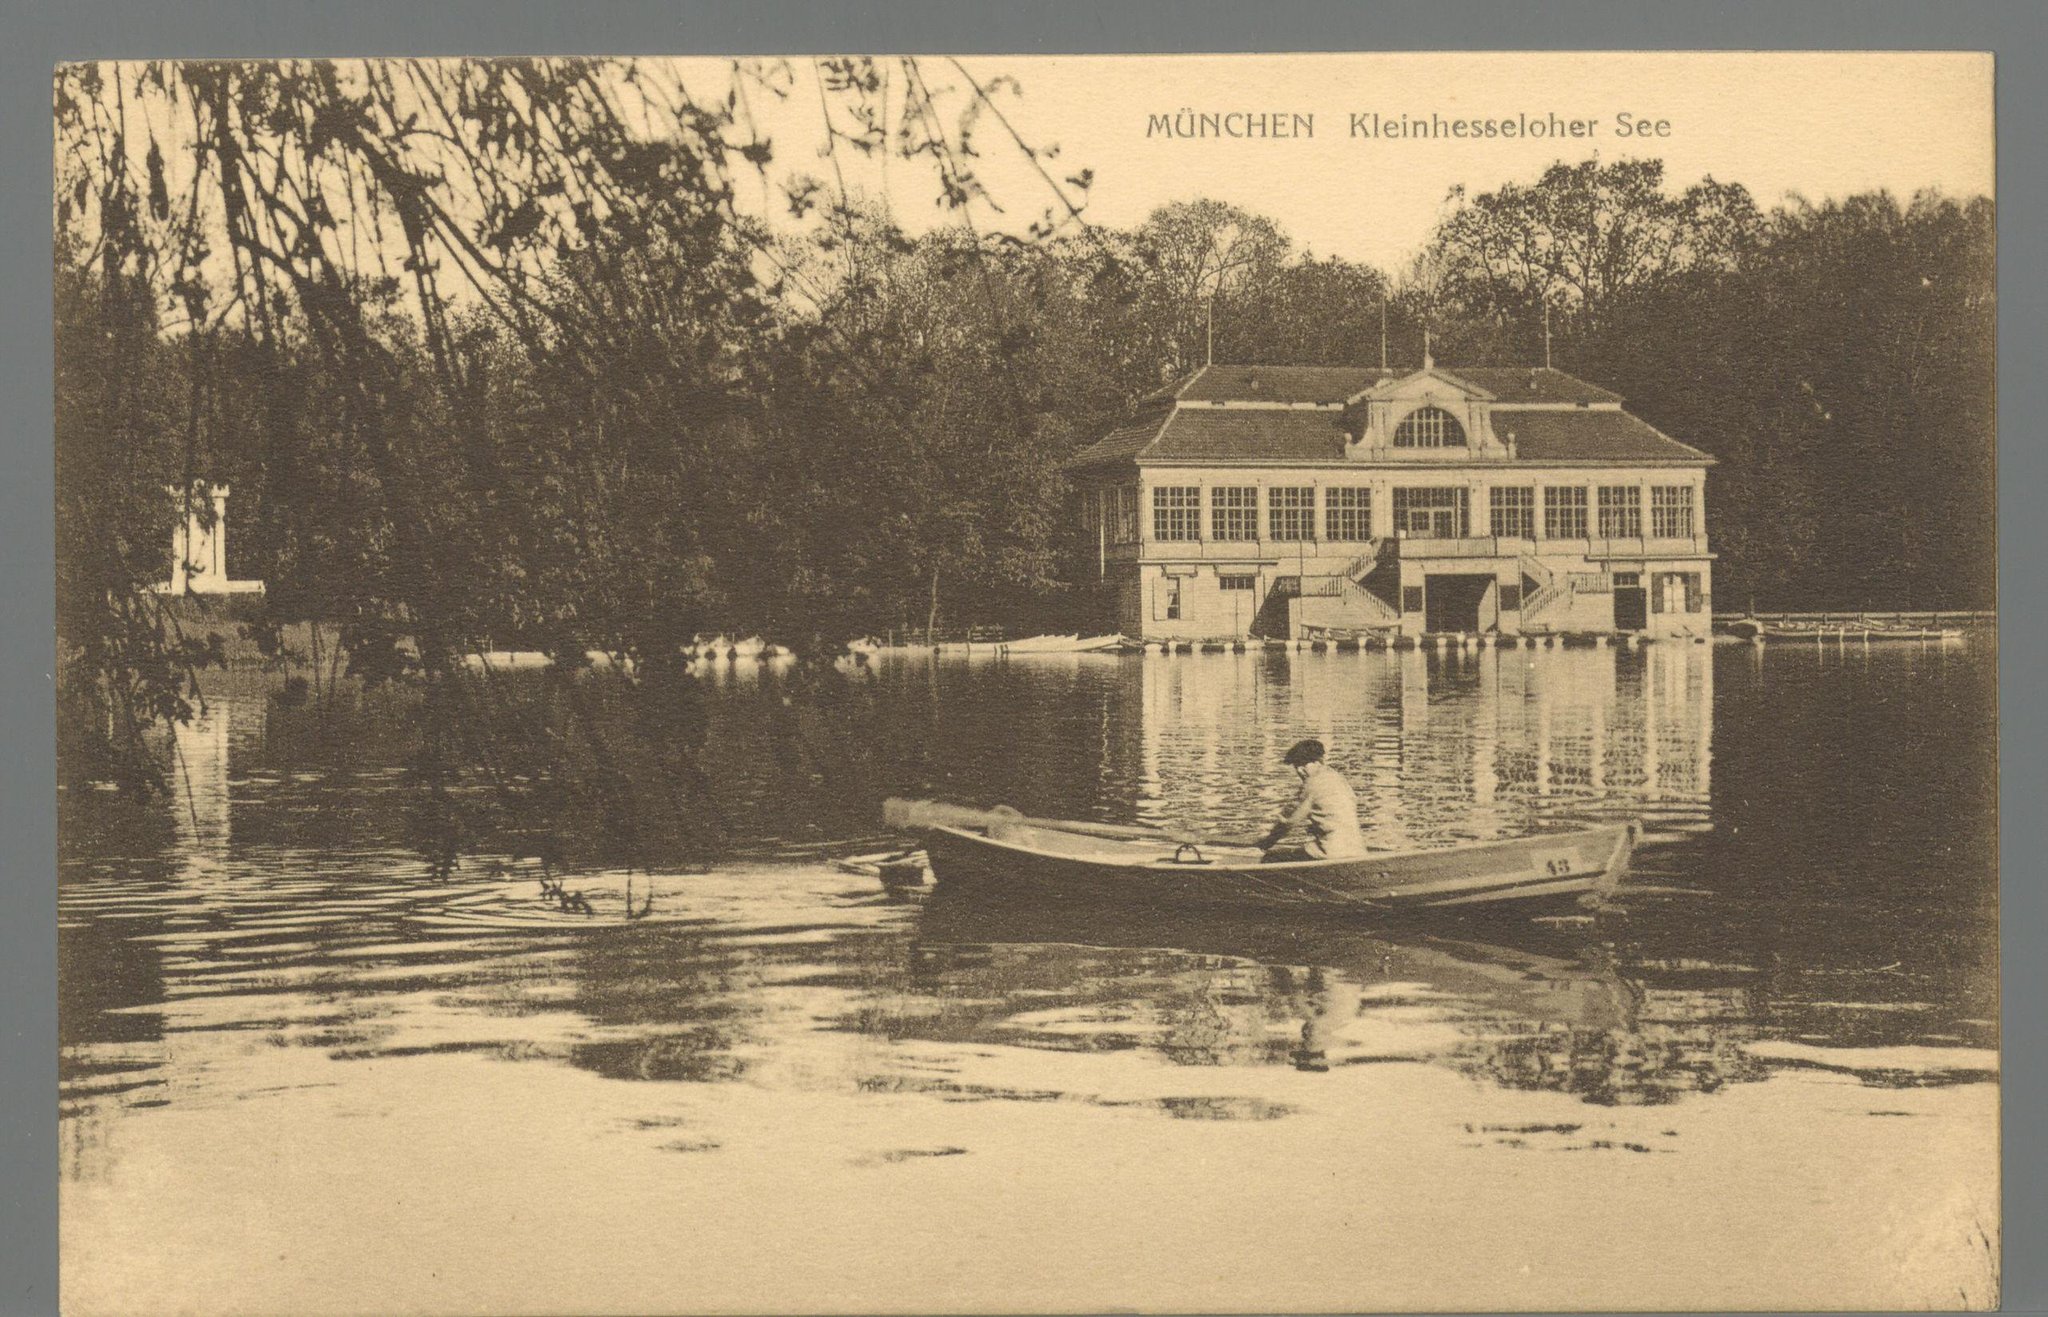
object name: photomechanical print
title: München. Kleinhesseloher See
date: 1905-1930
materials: cardboard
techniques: photograph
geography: munich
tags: park, lake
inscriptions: inscription: ‘W.H.D.’